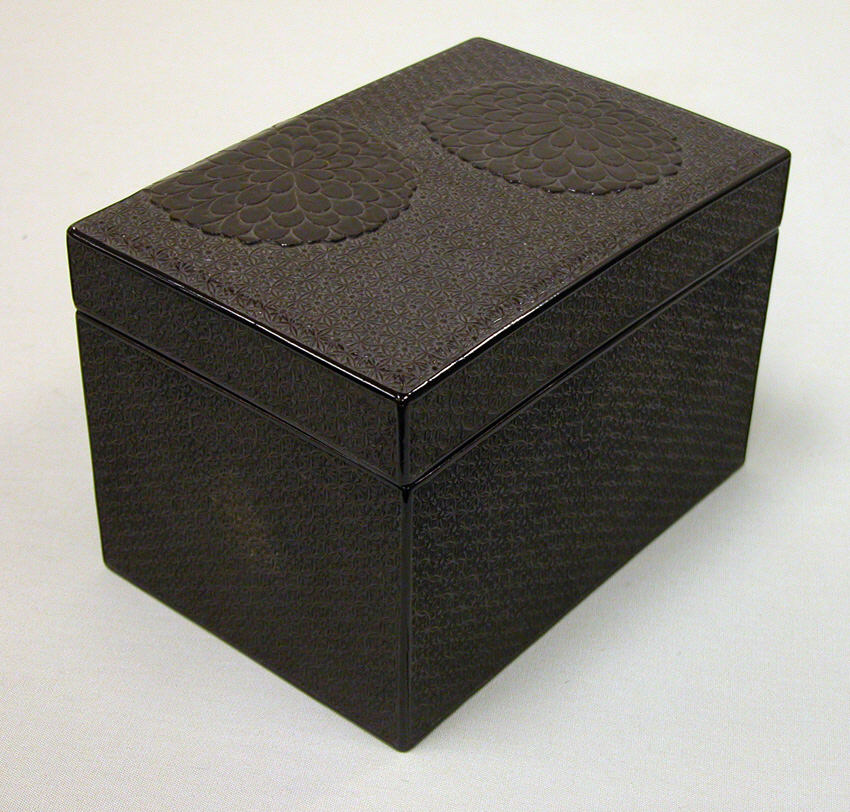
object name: box with tray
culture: japanese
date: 1701-1800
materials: lacquer